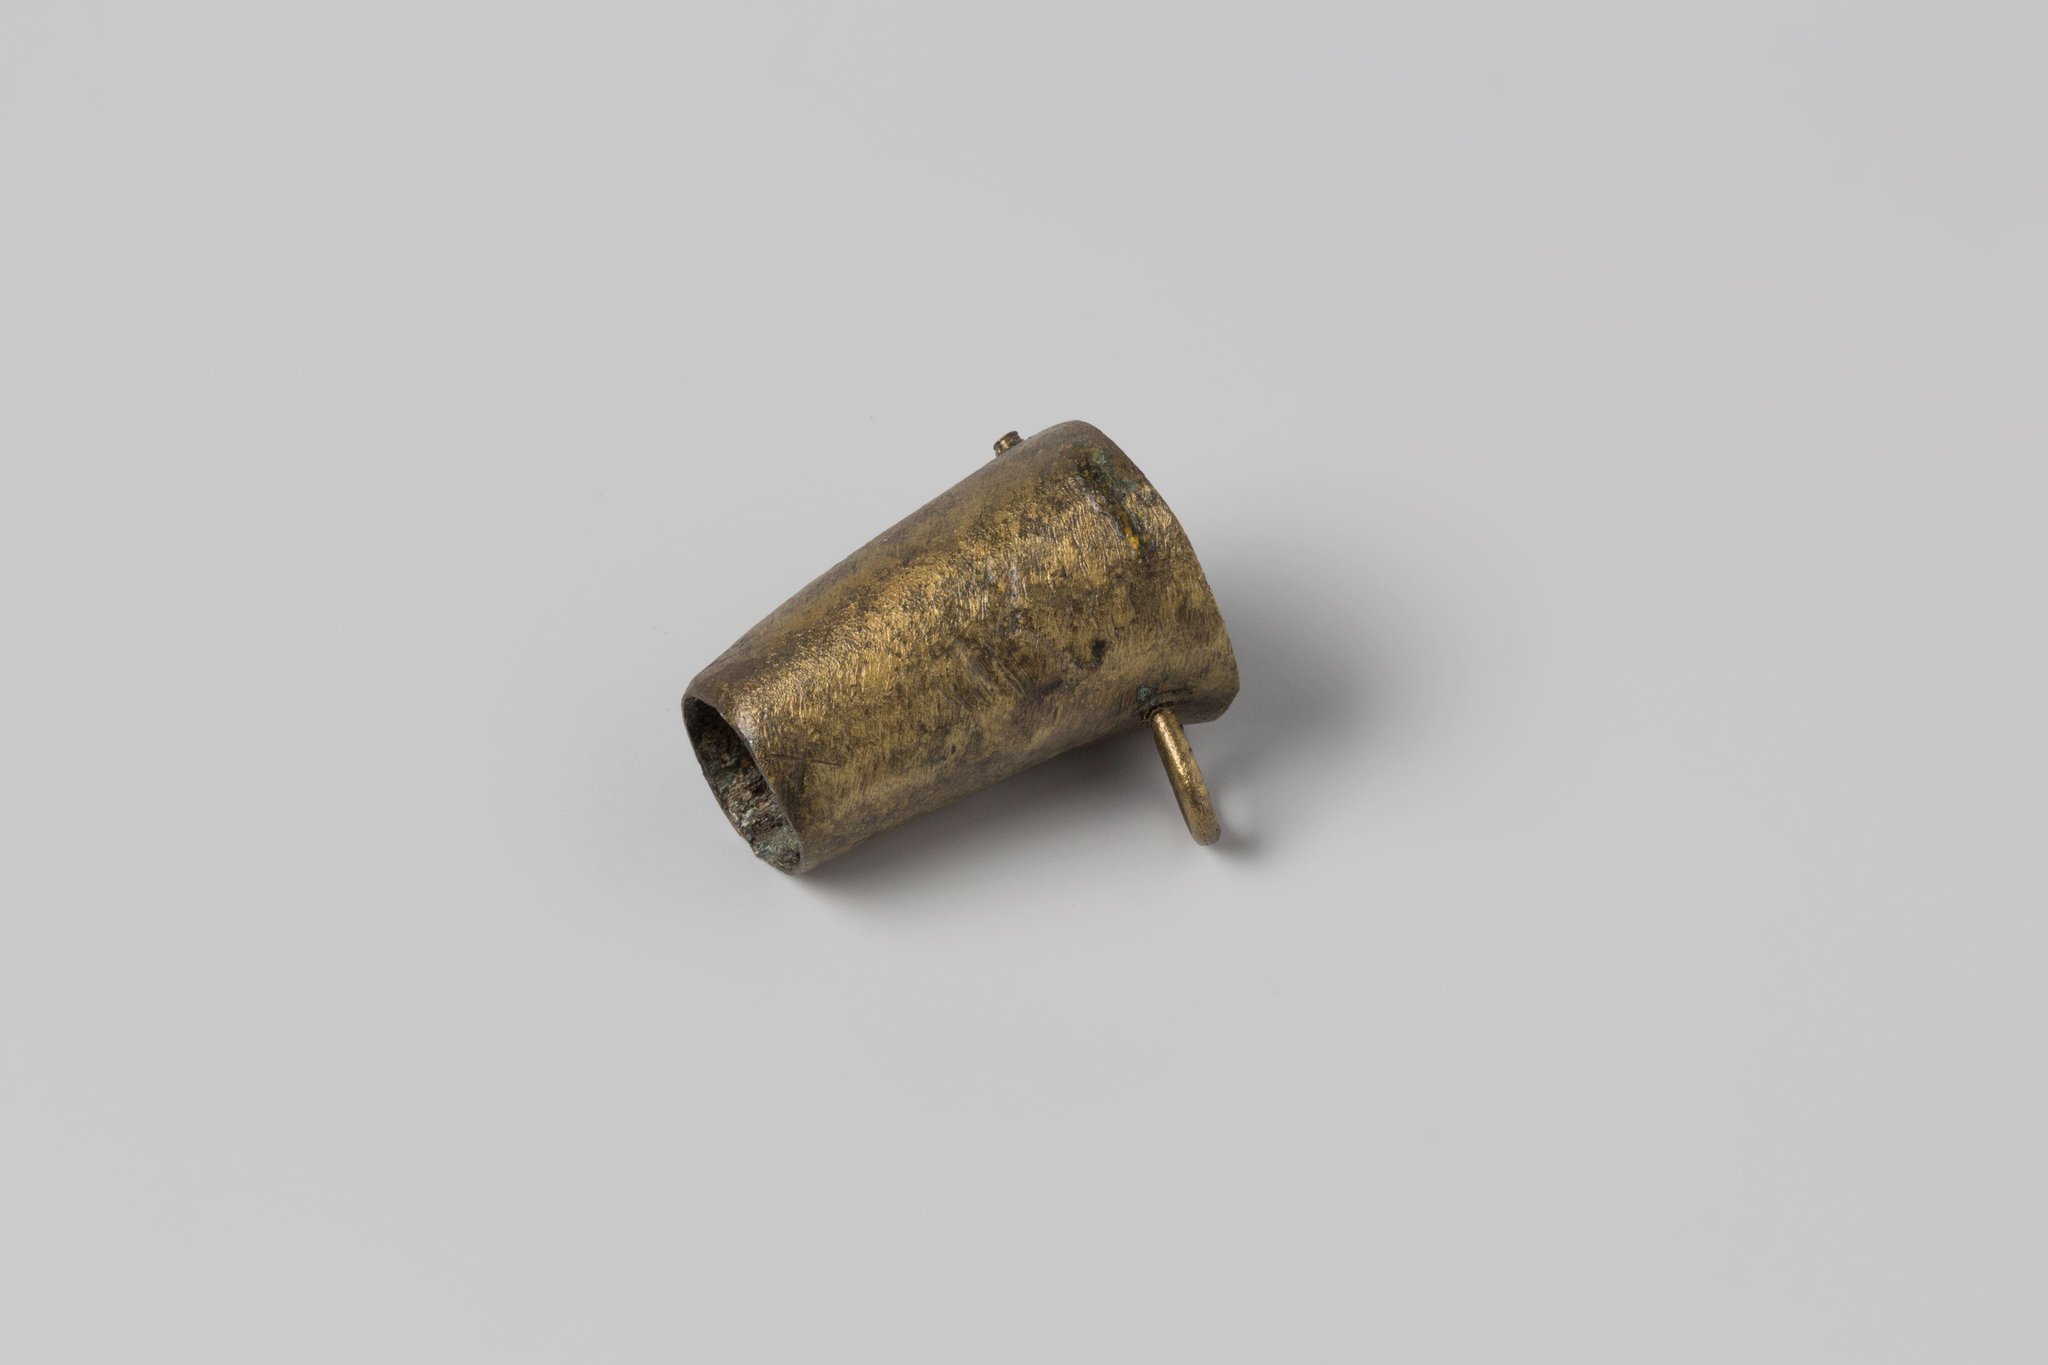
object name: powder horn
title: Part of a powderhorn from the wreck of the Dutch East Indiaman Hollandia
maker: Anonymous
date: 1700-1743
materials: copper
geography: netherlands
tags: verenigde oostindische compagnie, hollandia (schip), annet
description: Powderhorn, nozzle; id. NG 1979-52/53H636 with 1 copper wire screw eye with complete shaft.